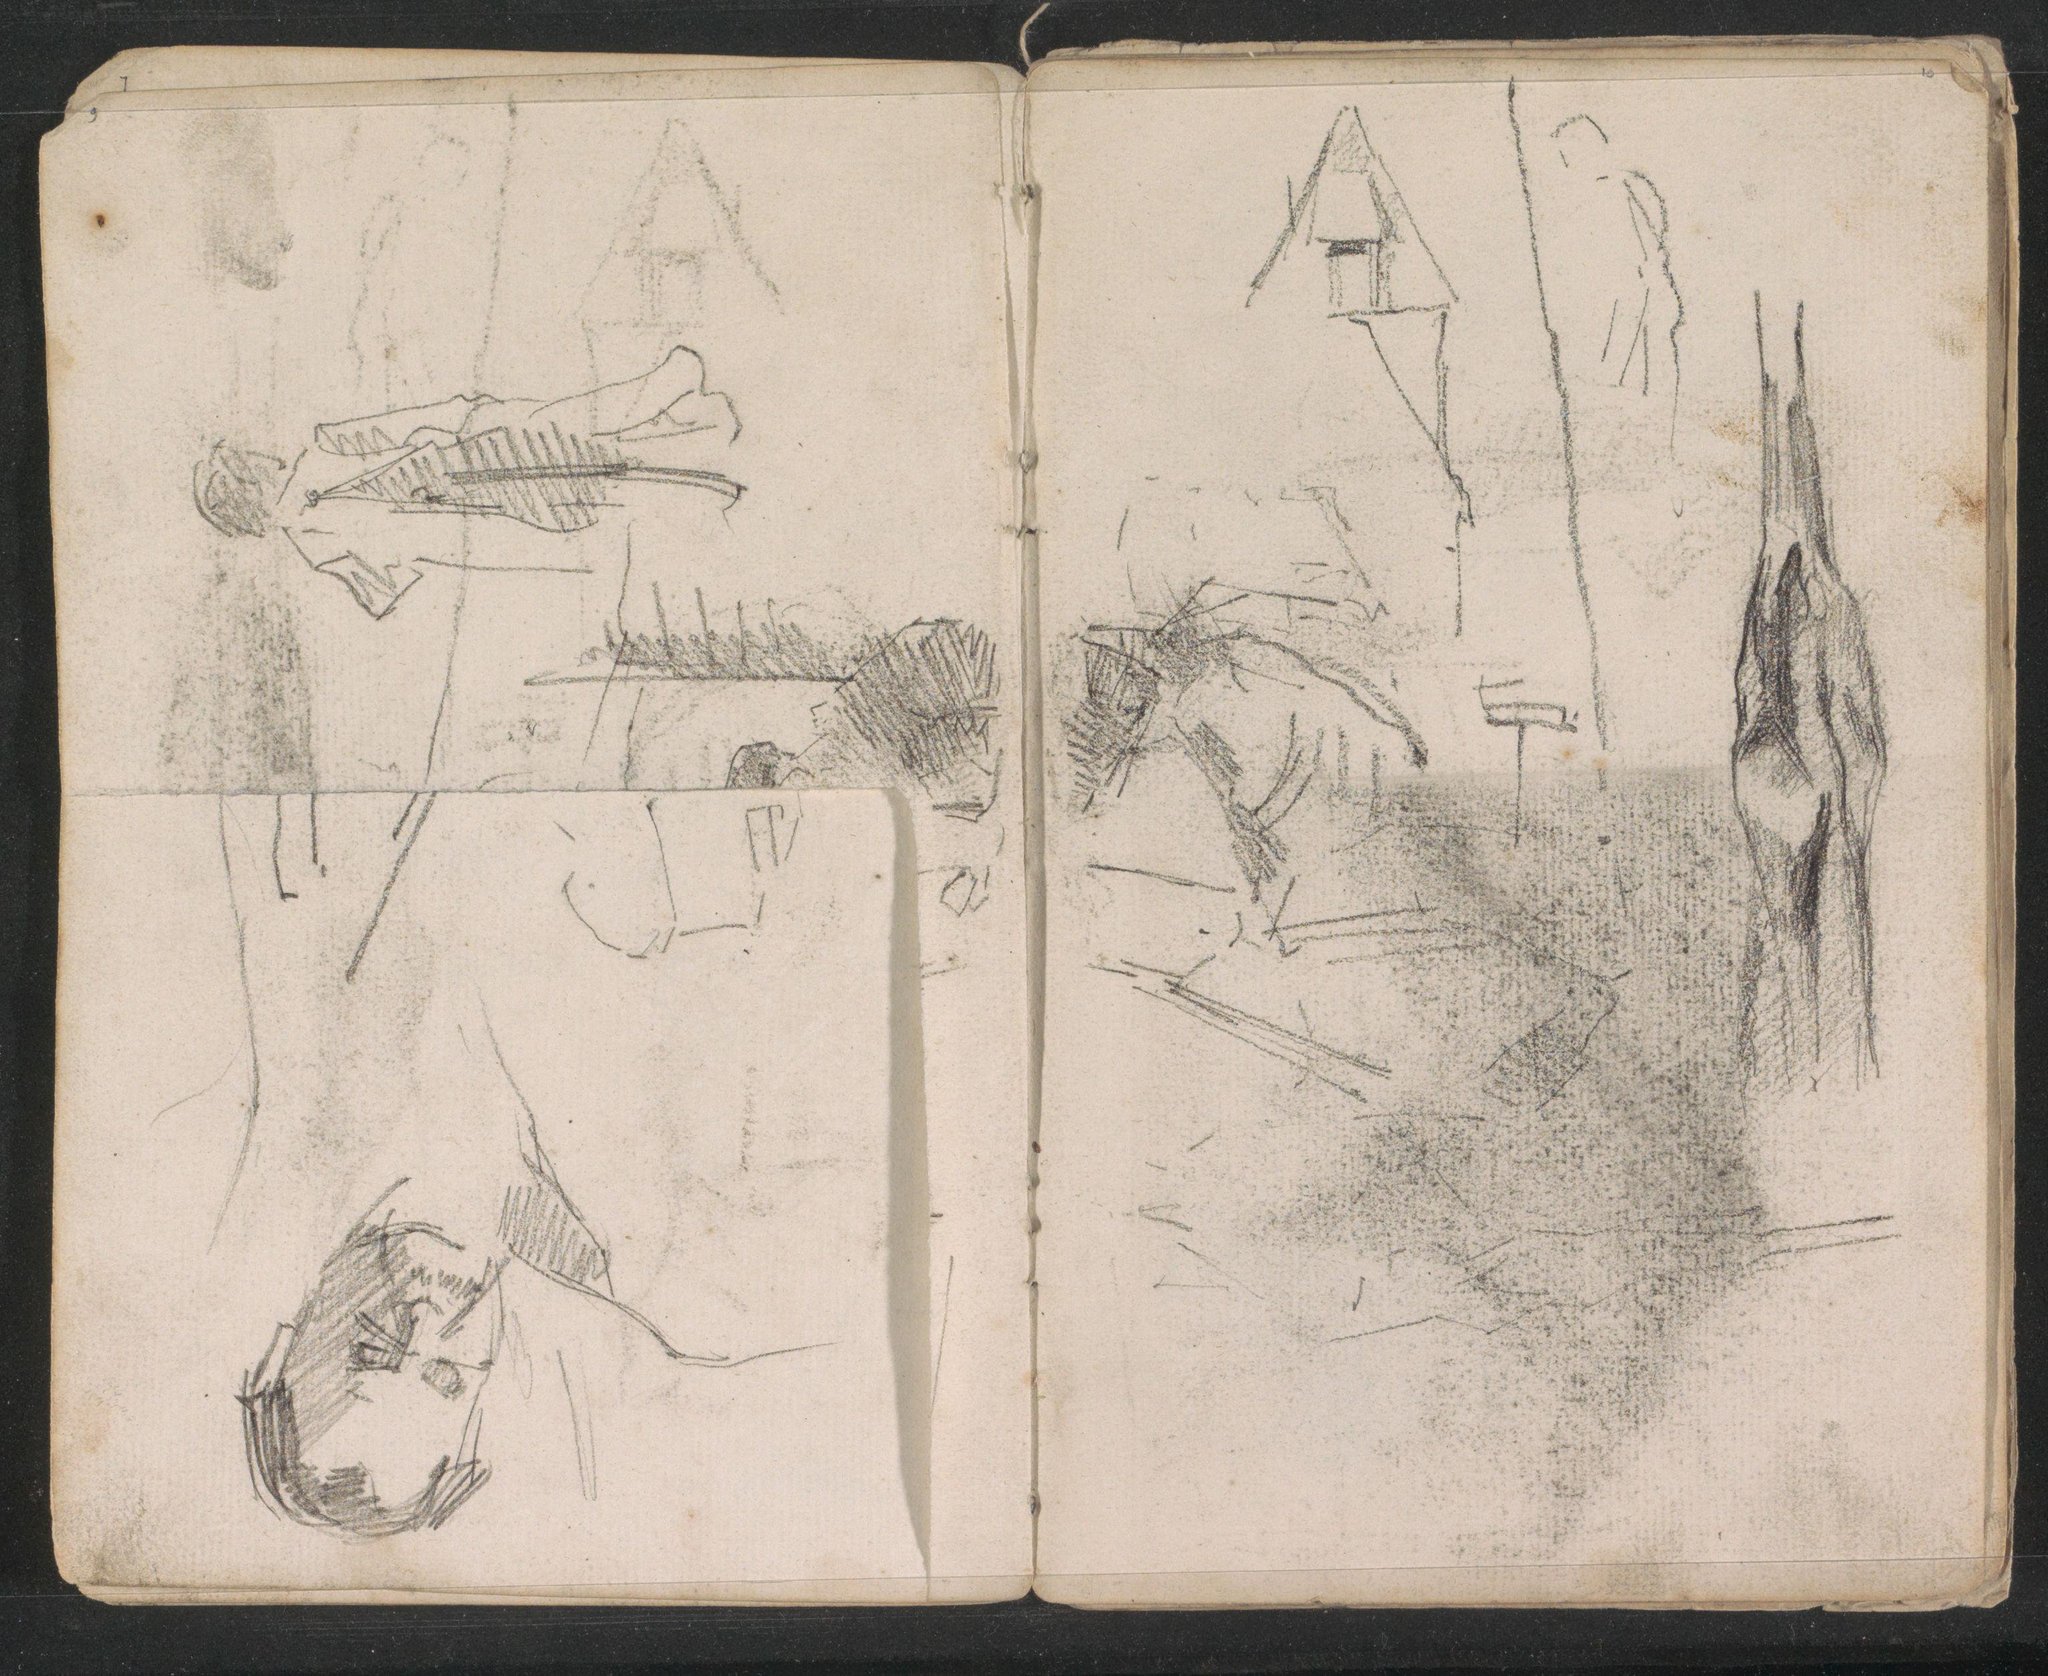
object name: sketchbook leaf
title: Studieblad met figuren, een gebouw en een paardenbeen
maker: george hendrik breitner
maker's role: draughtsman, painter, print maker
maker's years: 1857-1923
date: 1880-1882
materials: chalk, paper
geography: the hague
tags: adult woman, adult man, horse, architecture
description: Pagina 9 en pagina 10 uit een schetsboek met 29 bladen.